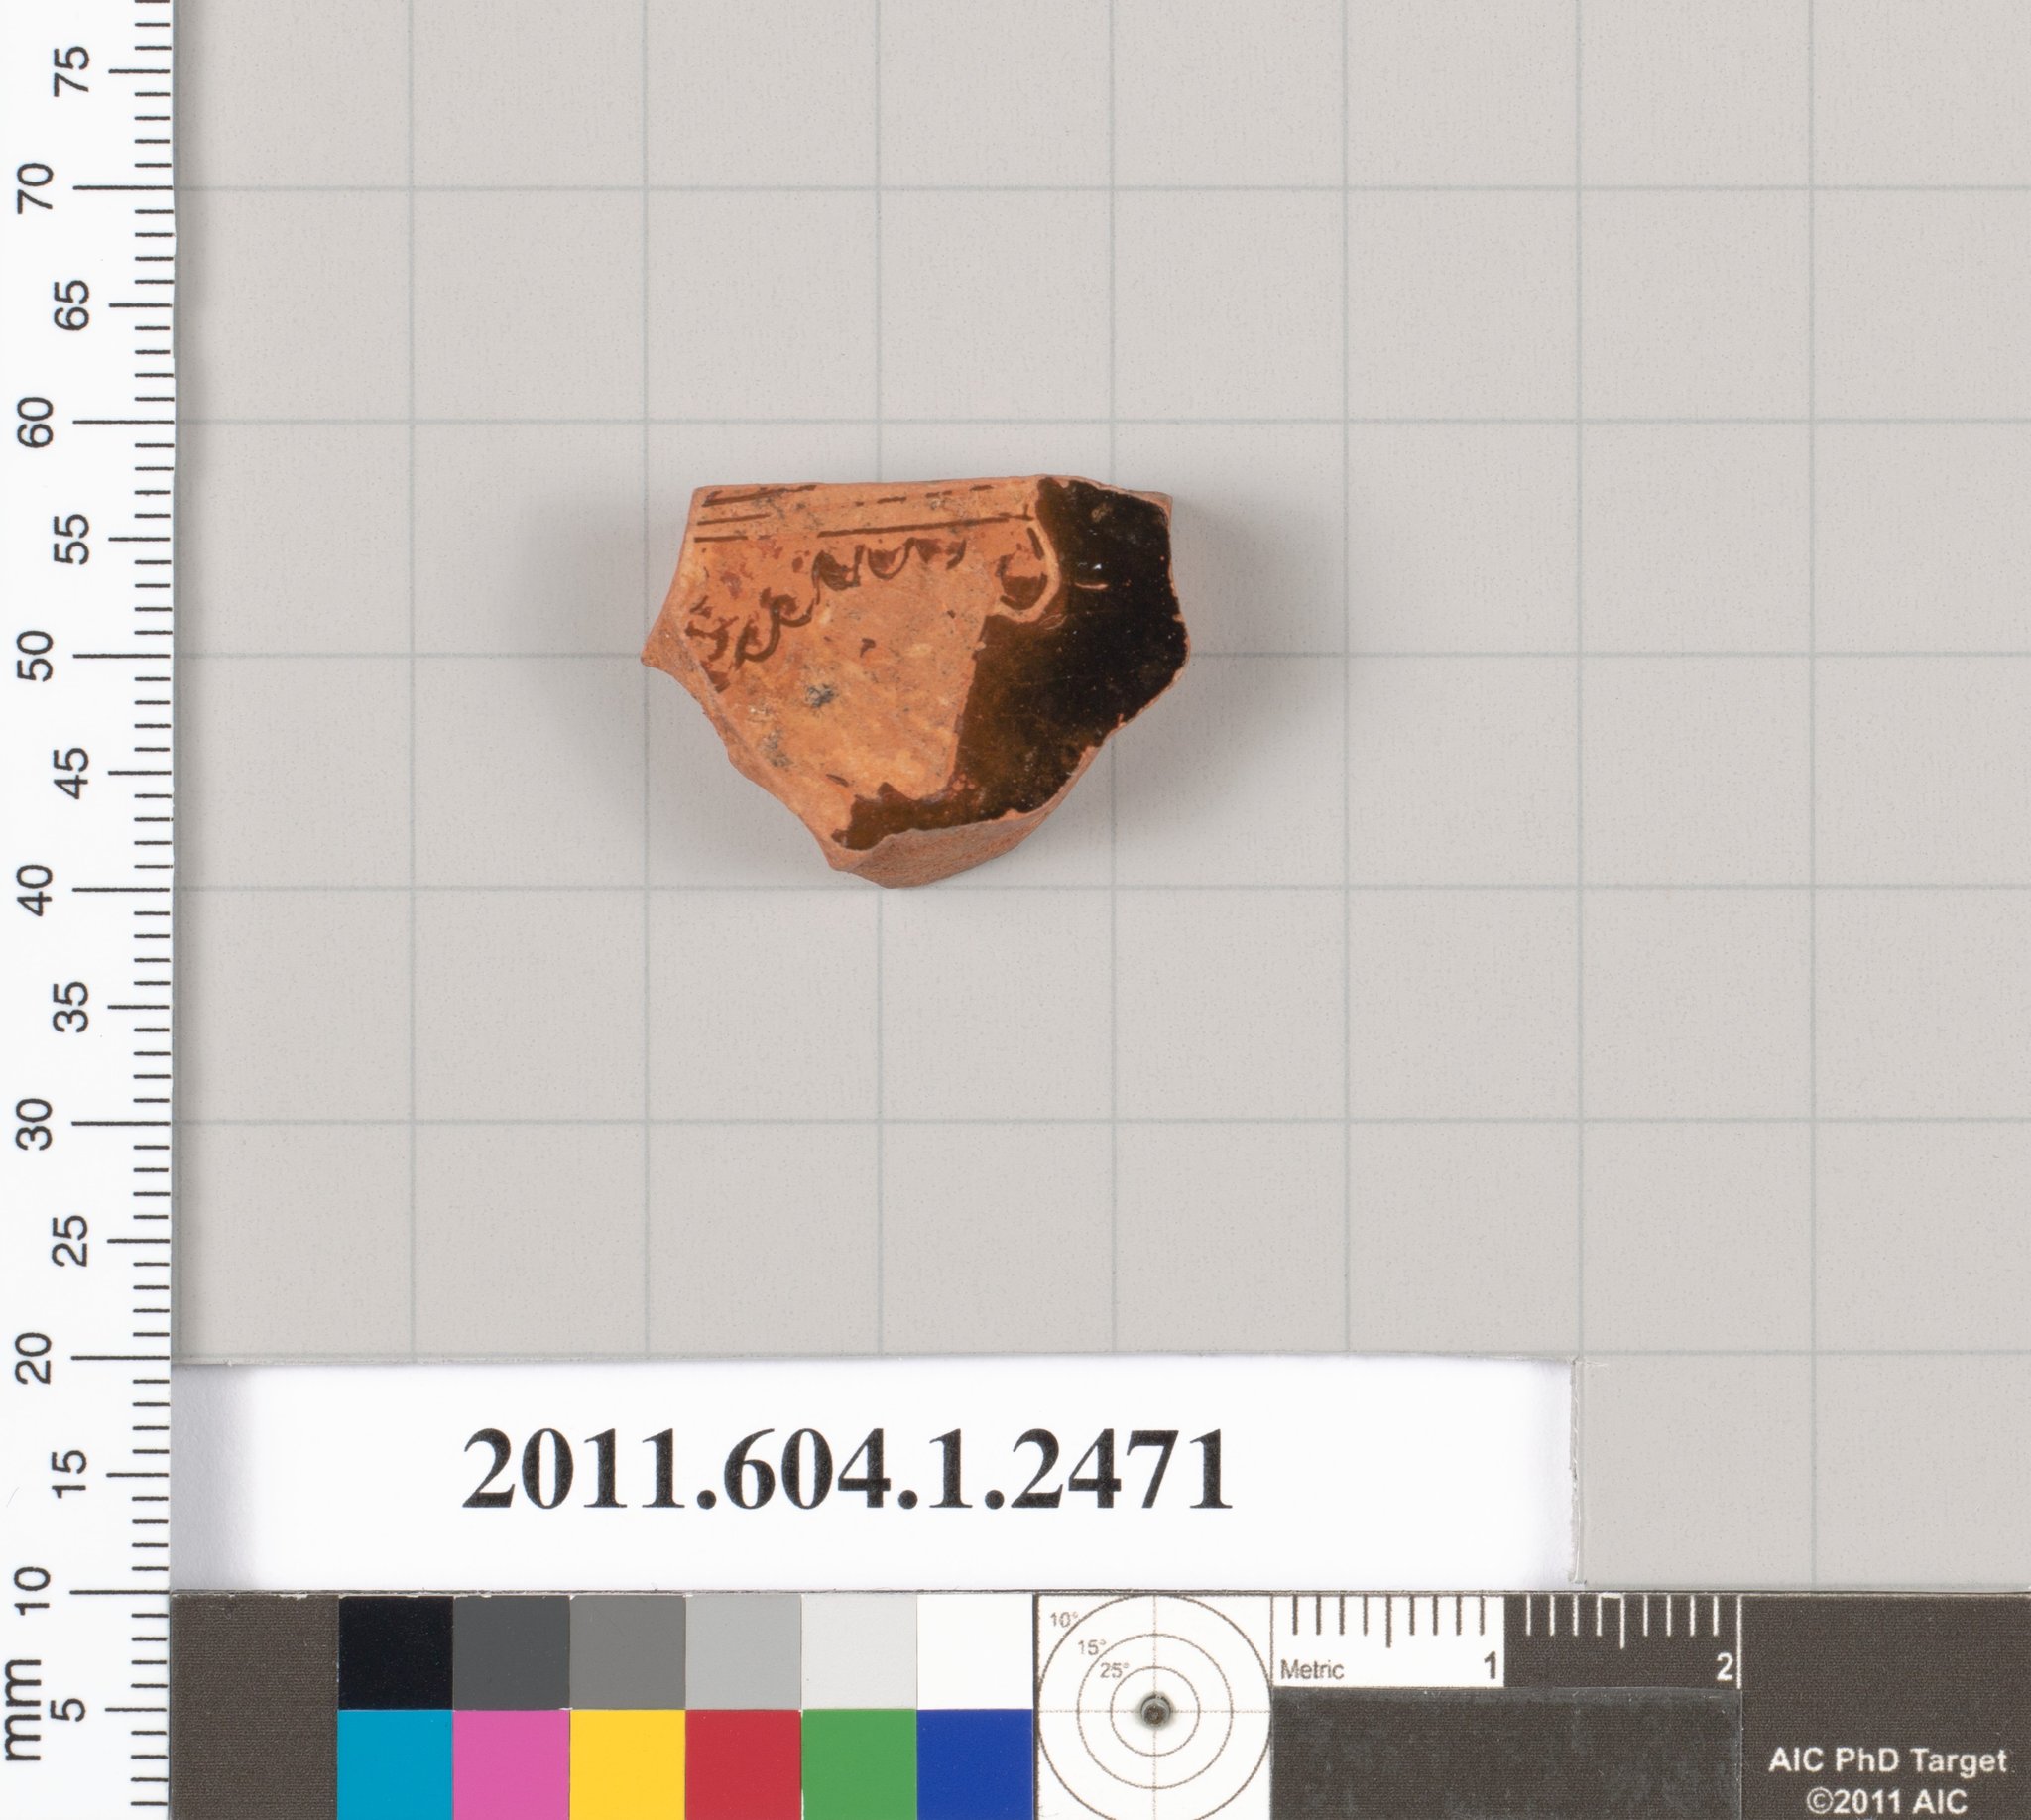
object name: kylix fragment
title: Terracotta fragment of a kylix (drinking cup)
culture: greek, attic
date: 500-476 BCE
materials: terracotta